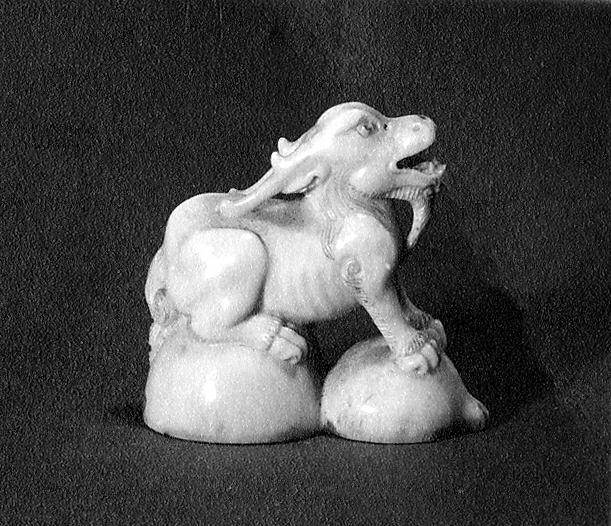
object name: seal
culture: chinese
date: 1701-1800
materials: ivory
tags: animals